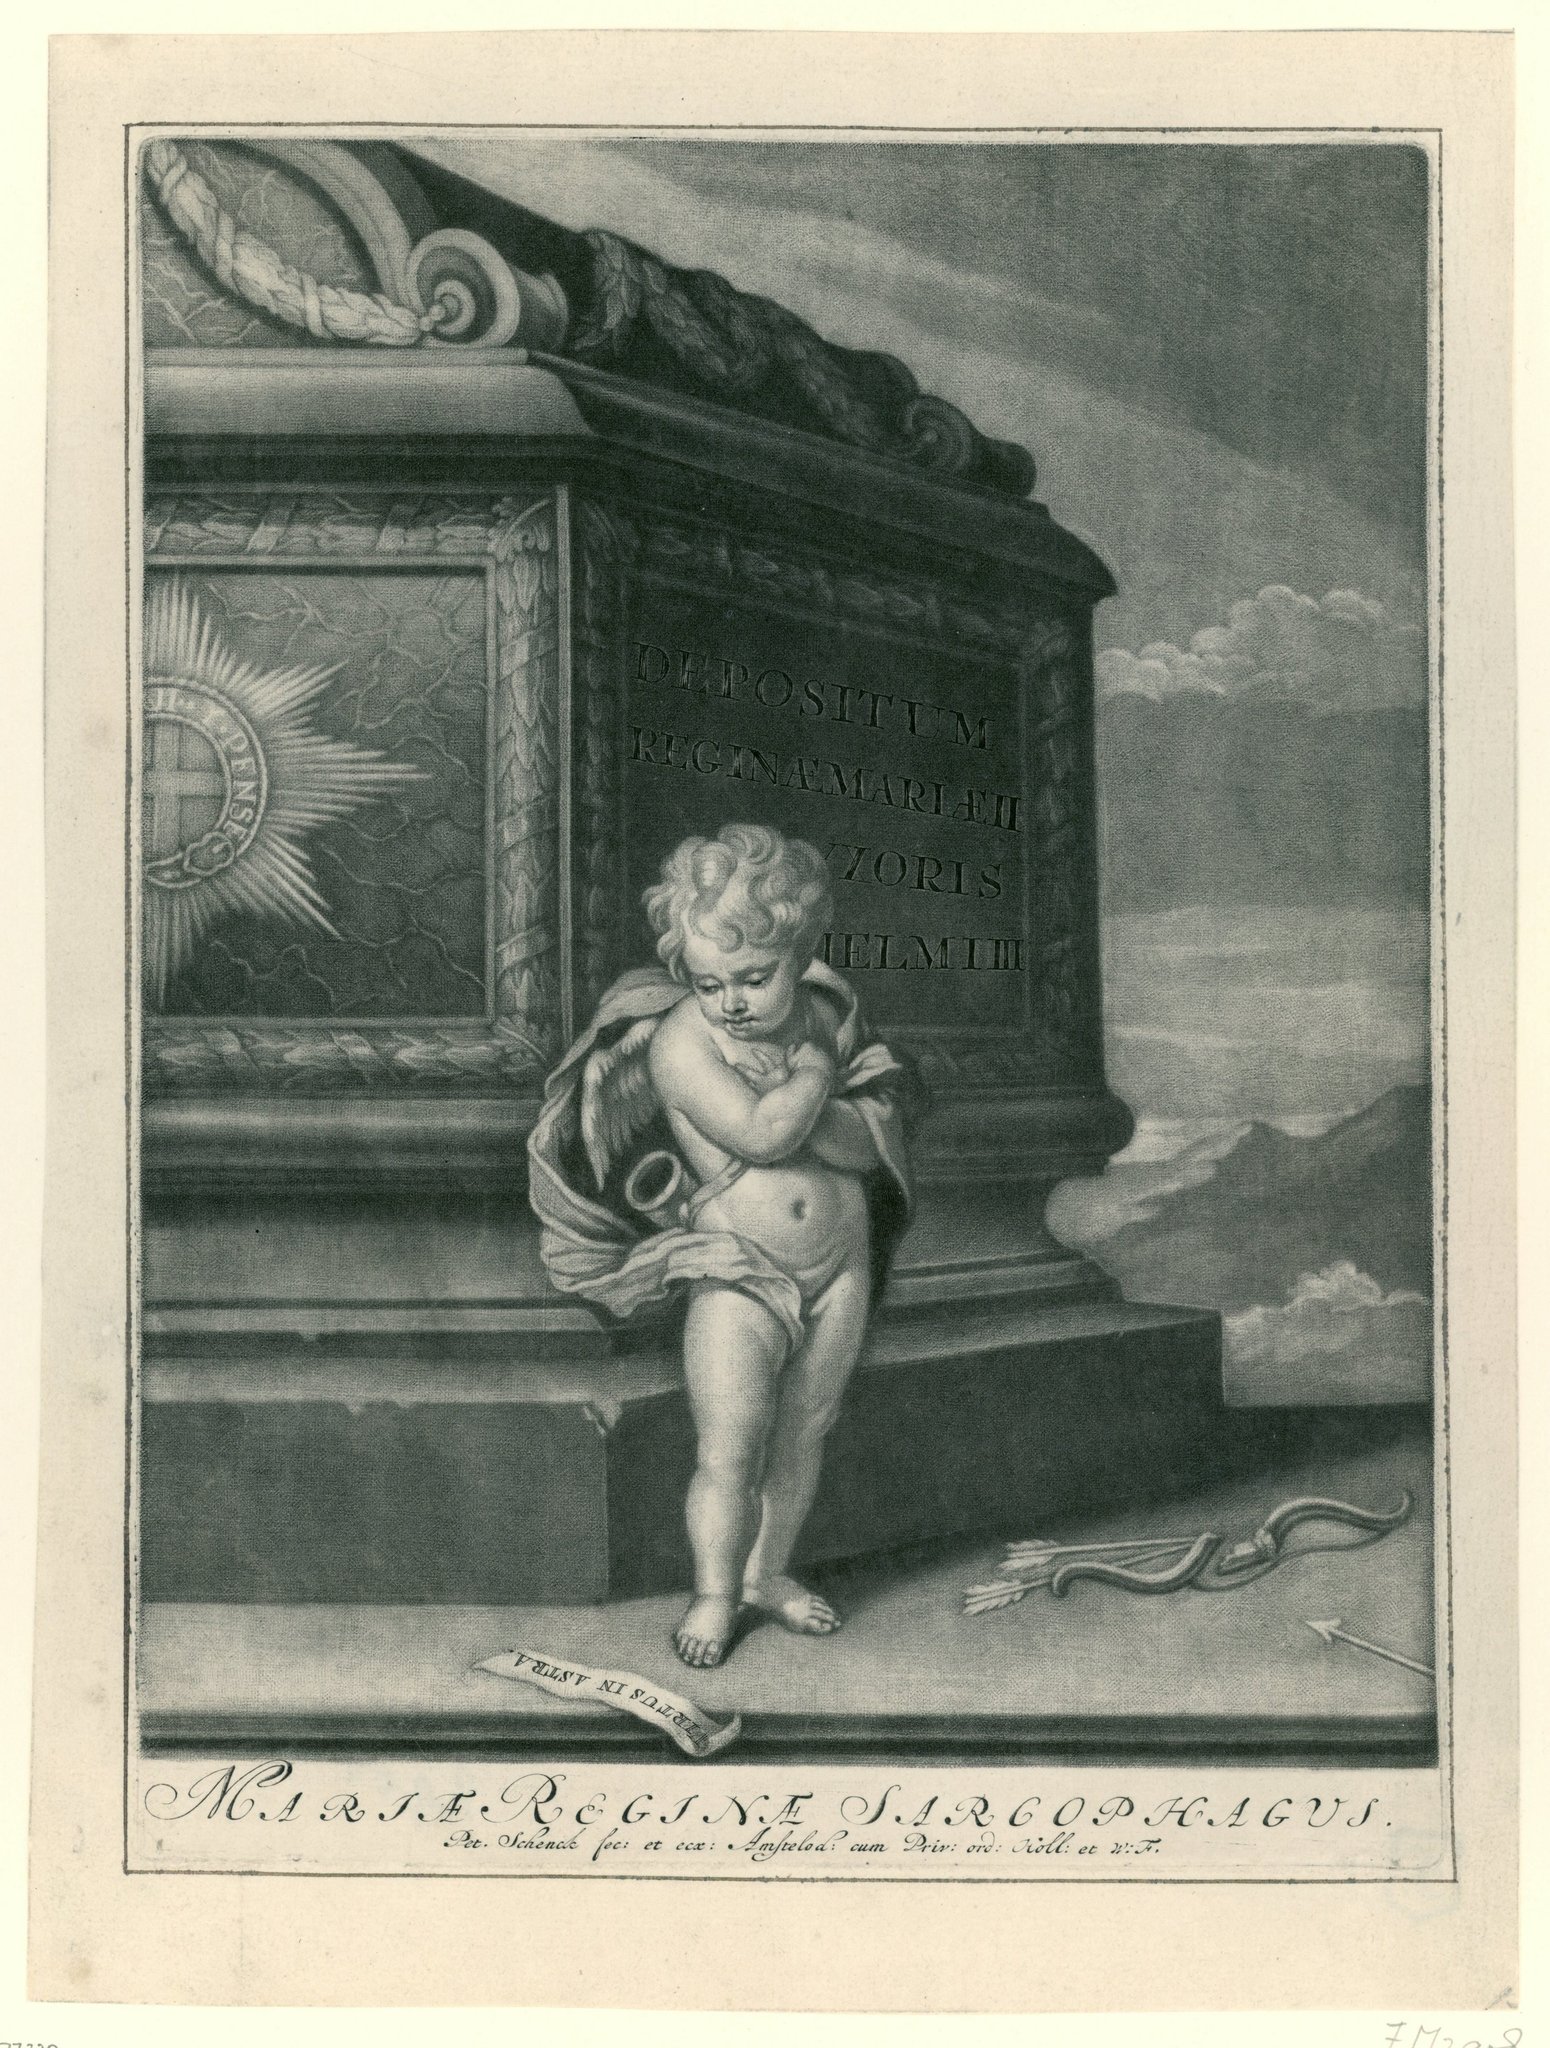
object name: print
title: Zinneprent ter nagedachtenis aan Maria Stuart, 1695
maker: pieter schenk (i)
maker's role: print maker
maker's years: 1660-1711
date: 1695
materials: paper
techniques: mezzotint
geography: amsterdam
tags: maria ii stuart (koningin van engeland, schotland en ierland), specific aspects of cupid, mourning the dead, grave-building, monumental tomb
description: Allegorische voorstelling vervaardigd ter nagedachtenis aan Maria II Stuart, overleden op 7 januari 1695. Een treurende Cupido staat bij het graf van de koningin. Met een Latijns onderschrift onder de prent en de naam op de graftombe. Op het strookje papier dat op de grond ligt staat de tekst 'Virtus in Astra'.